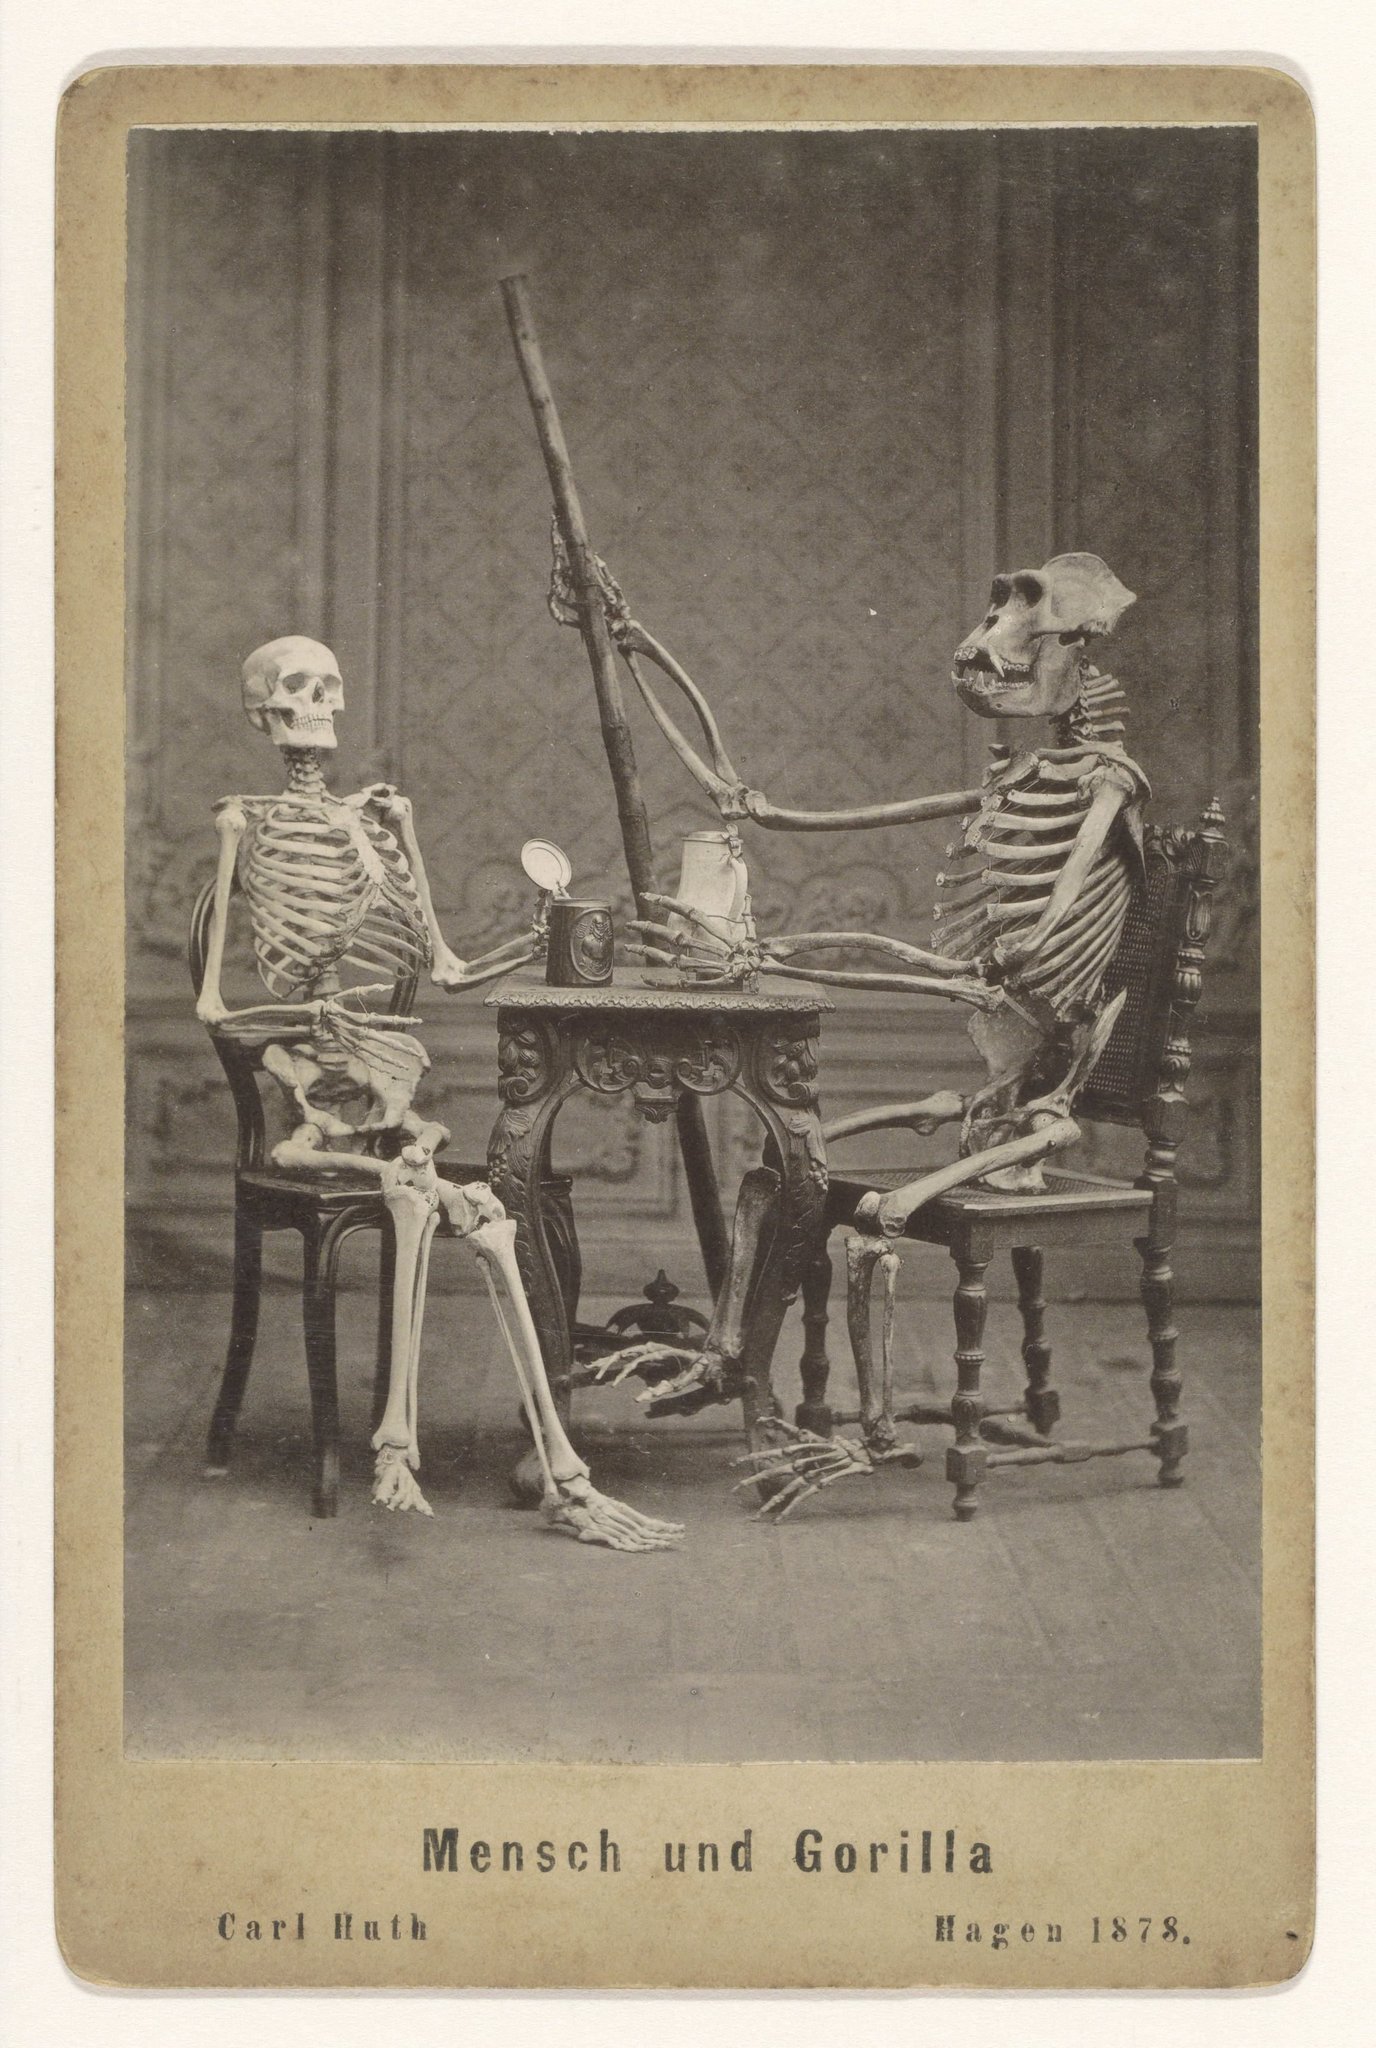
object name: photomechanical print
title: Mensch und Gorilla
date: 1878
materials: cardboard, paper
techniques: photograph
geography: hagen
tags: (human) skeleton, monkeys, apes (+ skeleton of an animal)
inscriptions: collector's mark: ‘Vosmaer’, inscription: ‘Carl Huth/ Hagen 1878.’